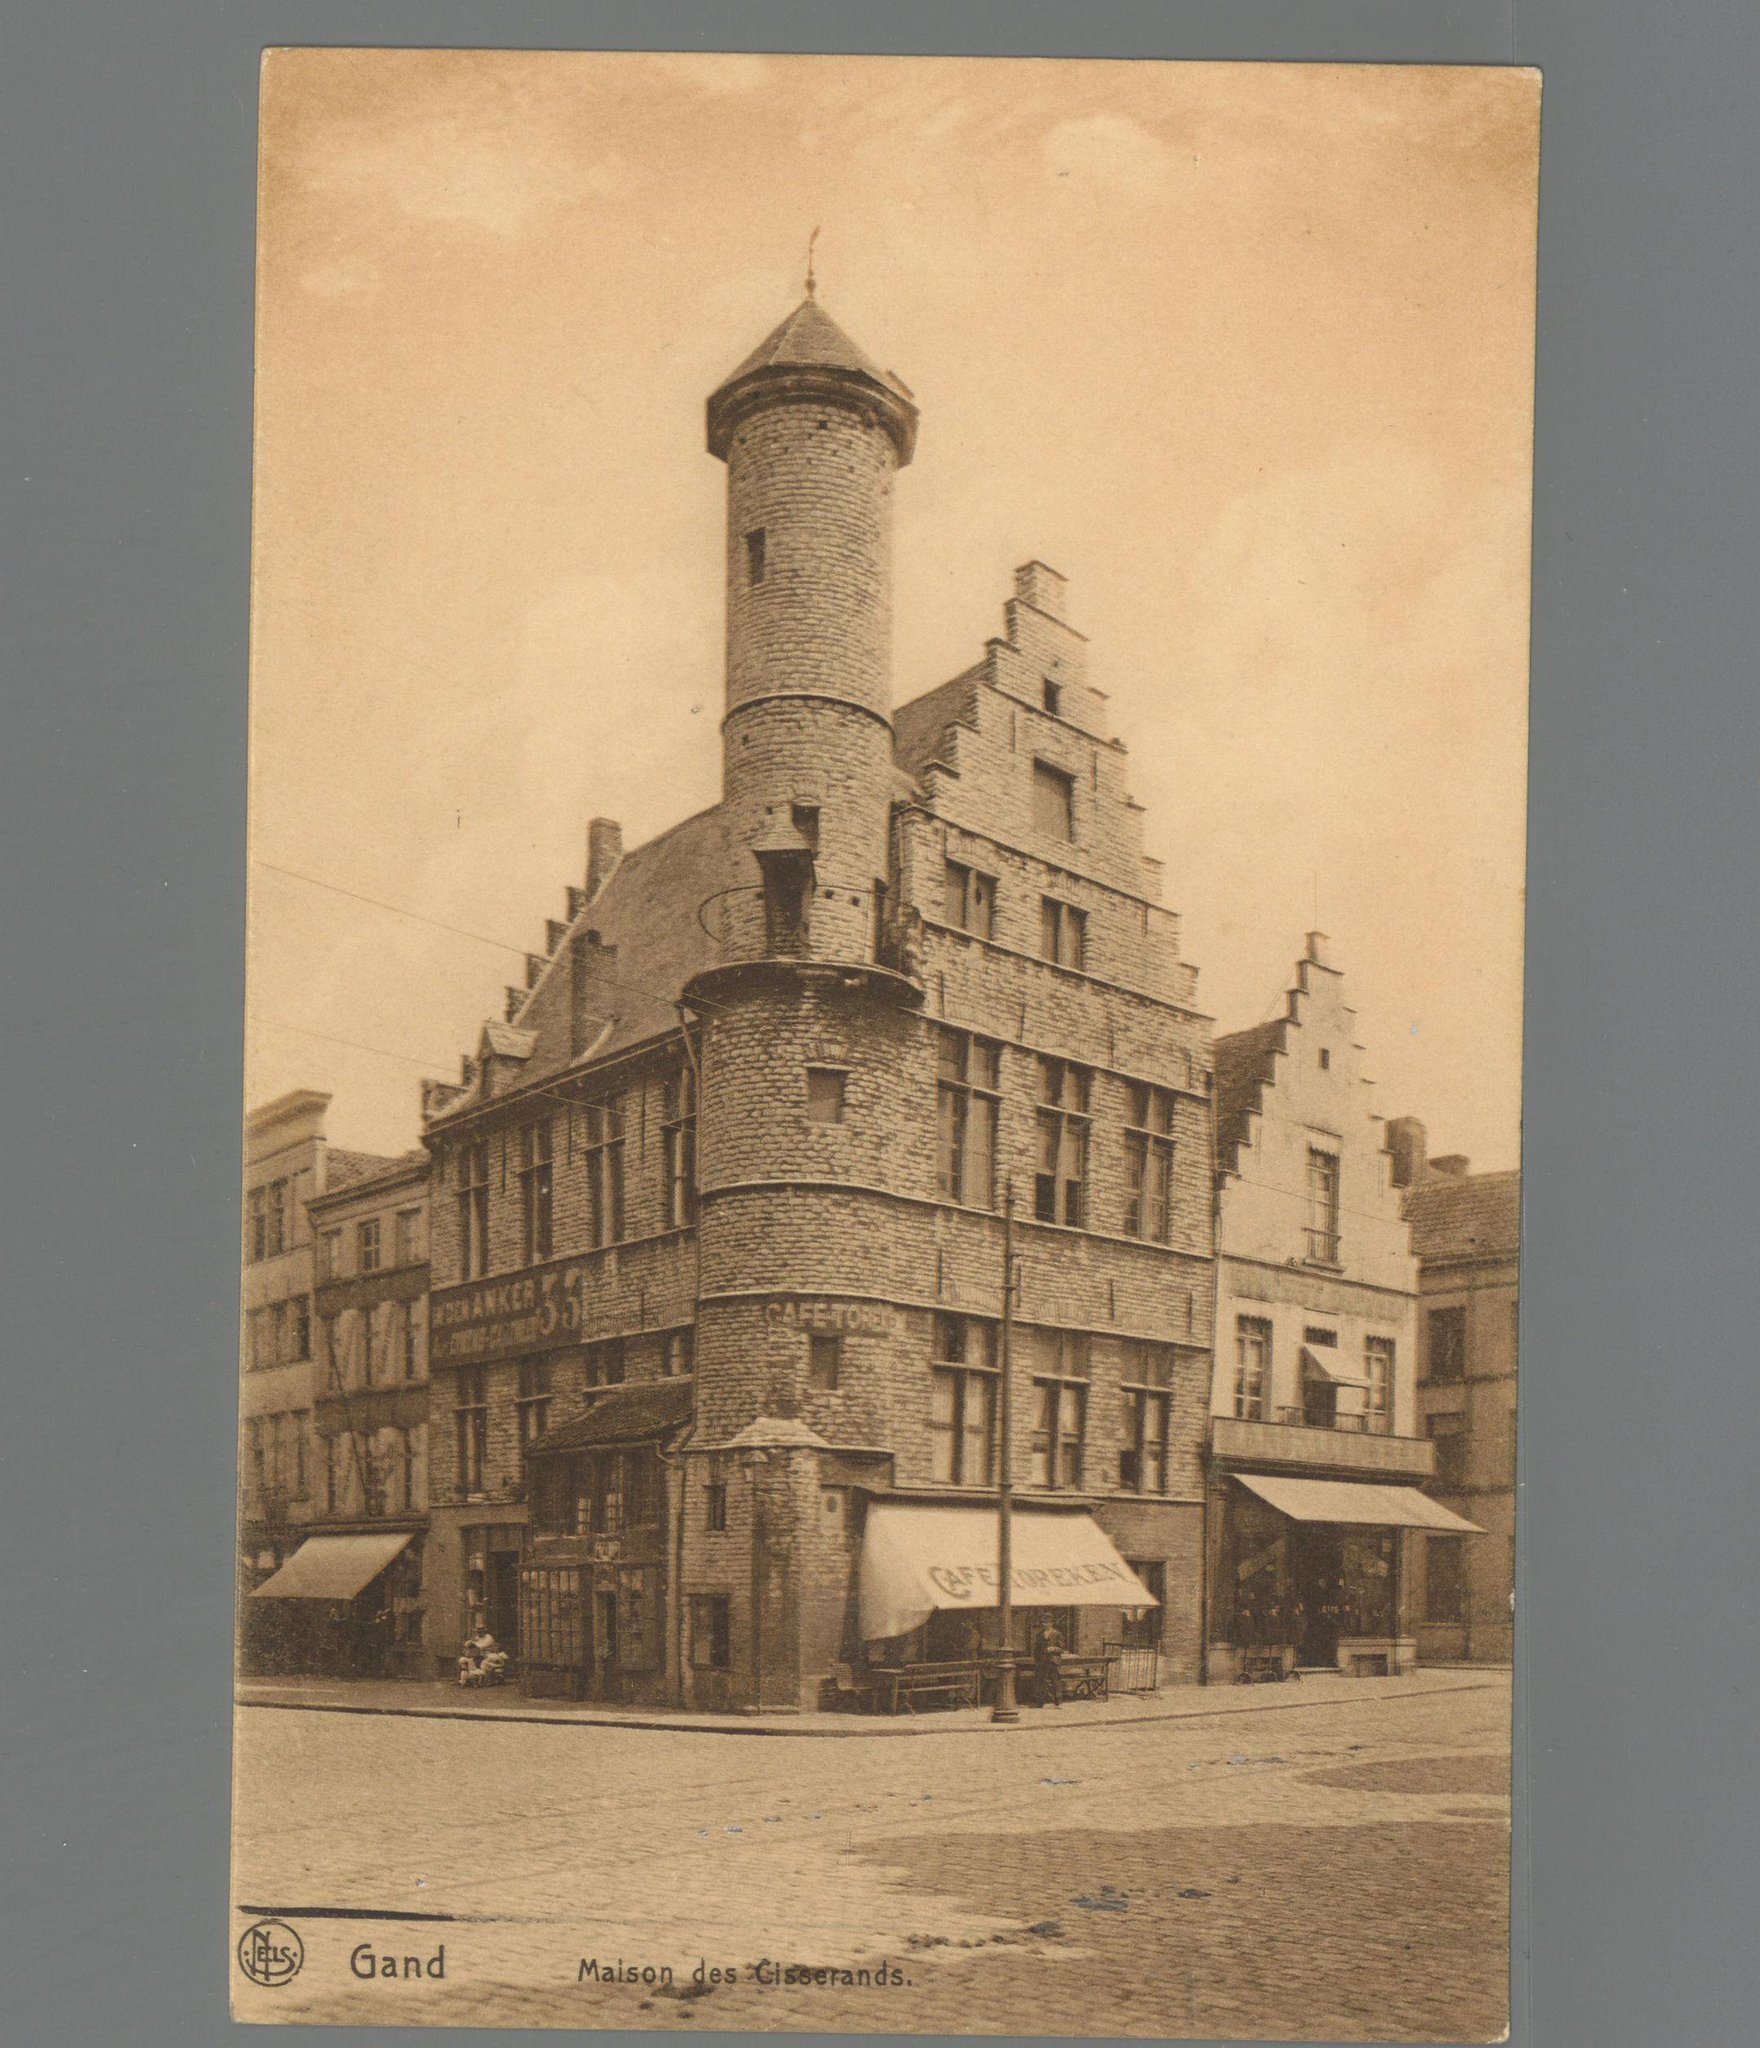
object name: ansichtkaart, prentbriefkaart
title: Gand. Maison des Cisserands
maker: Anonymous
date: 1907-1913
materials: cardboard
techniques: photograph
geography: brussels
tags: urban housing, city-view, and landscape with man-made constructions (+ city(-scape) with figures, staffage), ghent